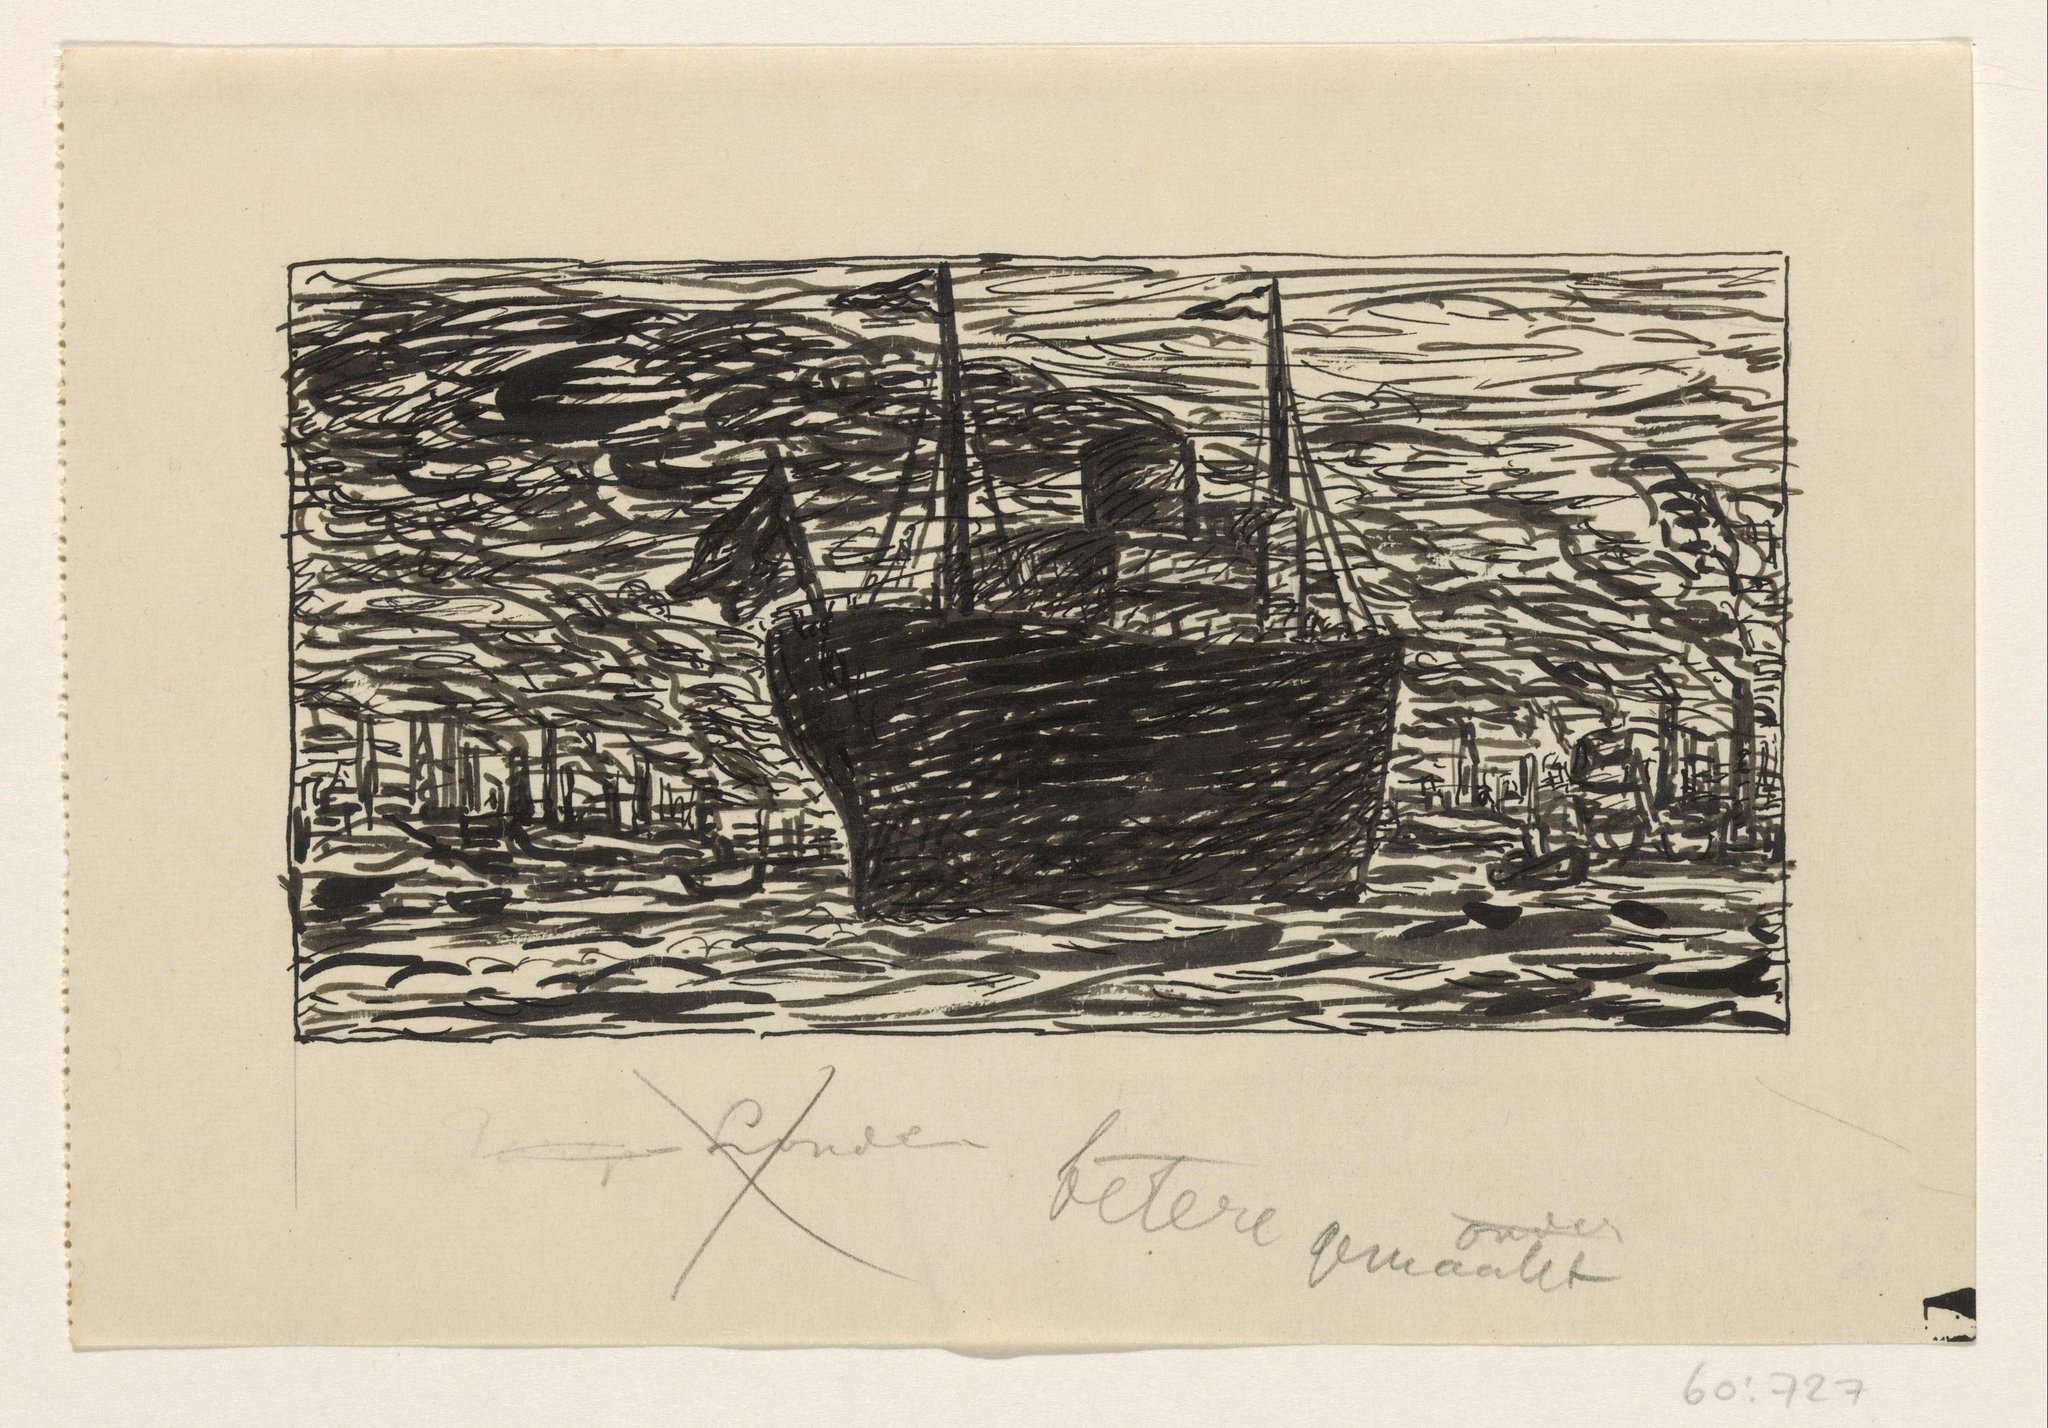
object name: boekillustratie ontwerp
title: Schip vaart de haven van Londen binnen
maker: leo gestel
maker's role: draughtsman, print maker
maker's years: 1881-1941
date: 1934-1936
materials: ink, paper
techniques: brush, pen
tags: harbour, (cohen, van anarchist tot monarchist) specific works of literature (with author, title), ships (in general) (+ arrival, coming to anchor, at anchor), london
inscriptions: collector's mark: Lugt 2228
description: Ontwerp voor een boekillustratie voor: Cohen, Alexander. Van anarchist tot monarchist. Amsterdam: De Steenuil, 1936.